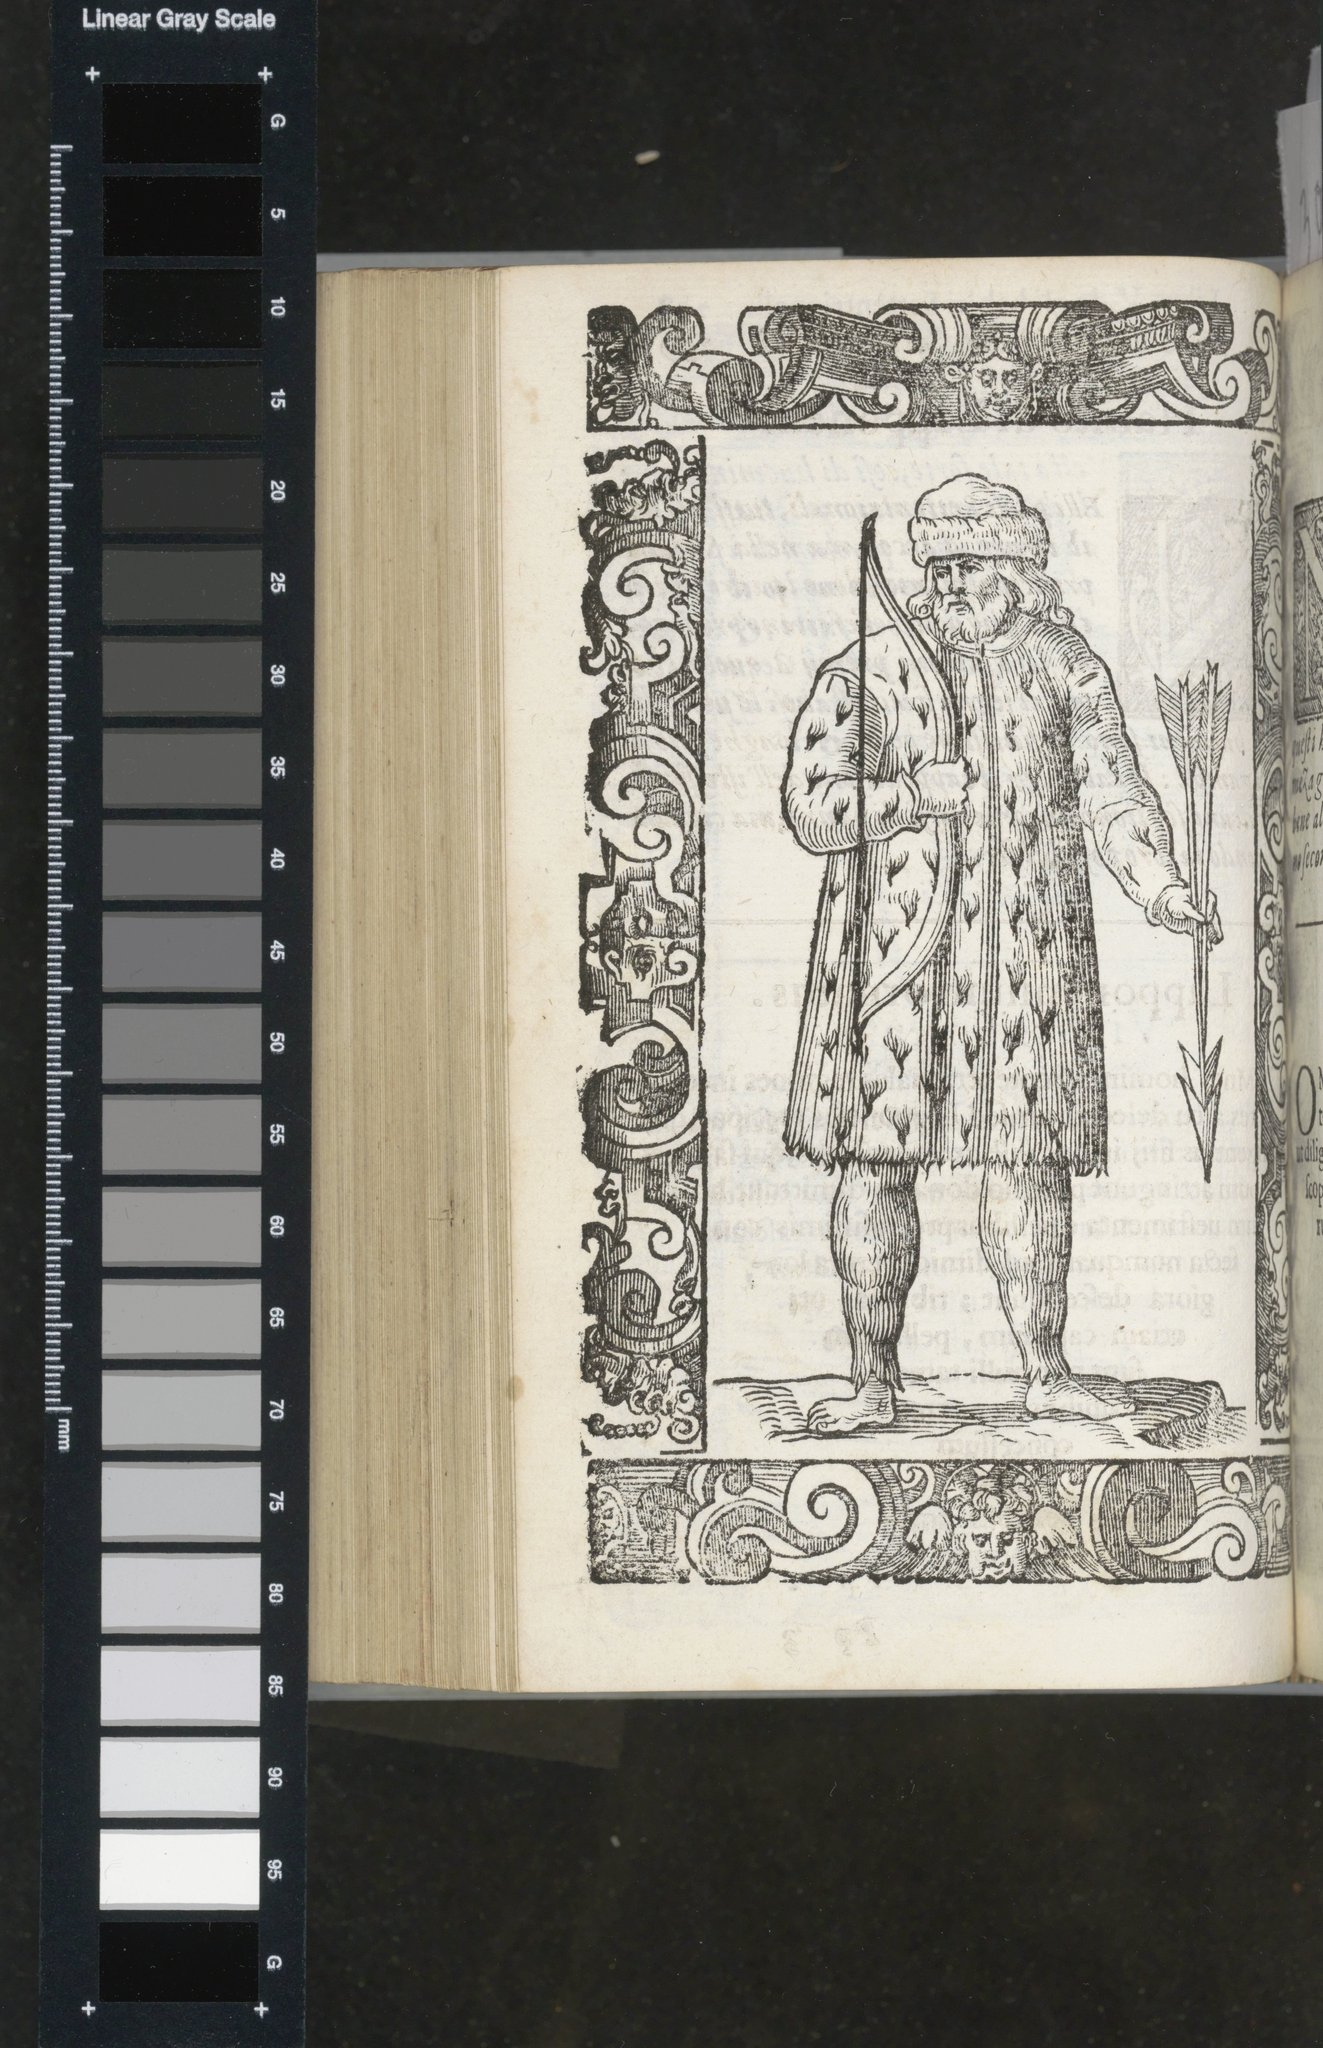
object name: costume print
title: Habito di Lapponesi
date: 1598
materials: paper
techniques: woodcut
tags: fashion plates